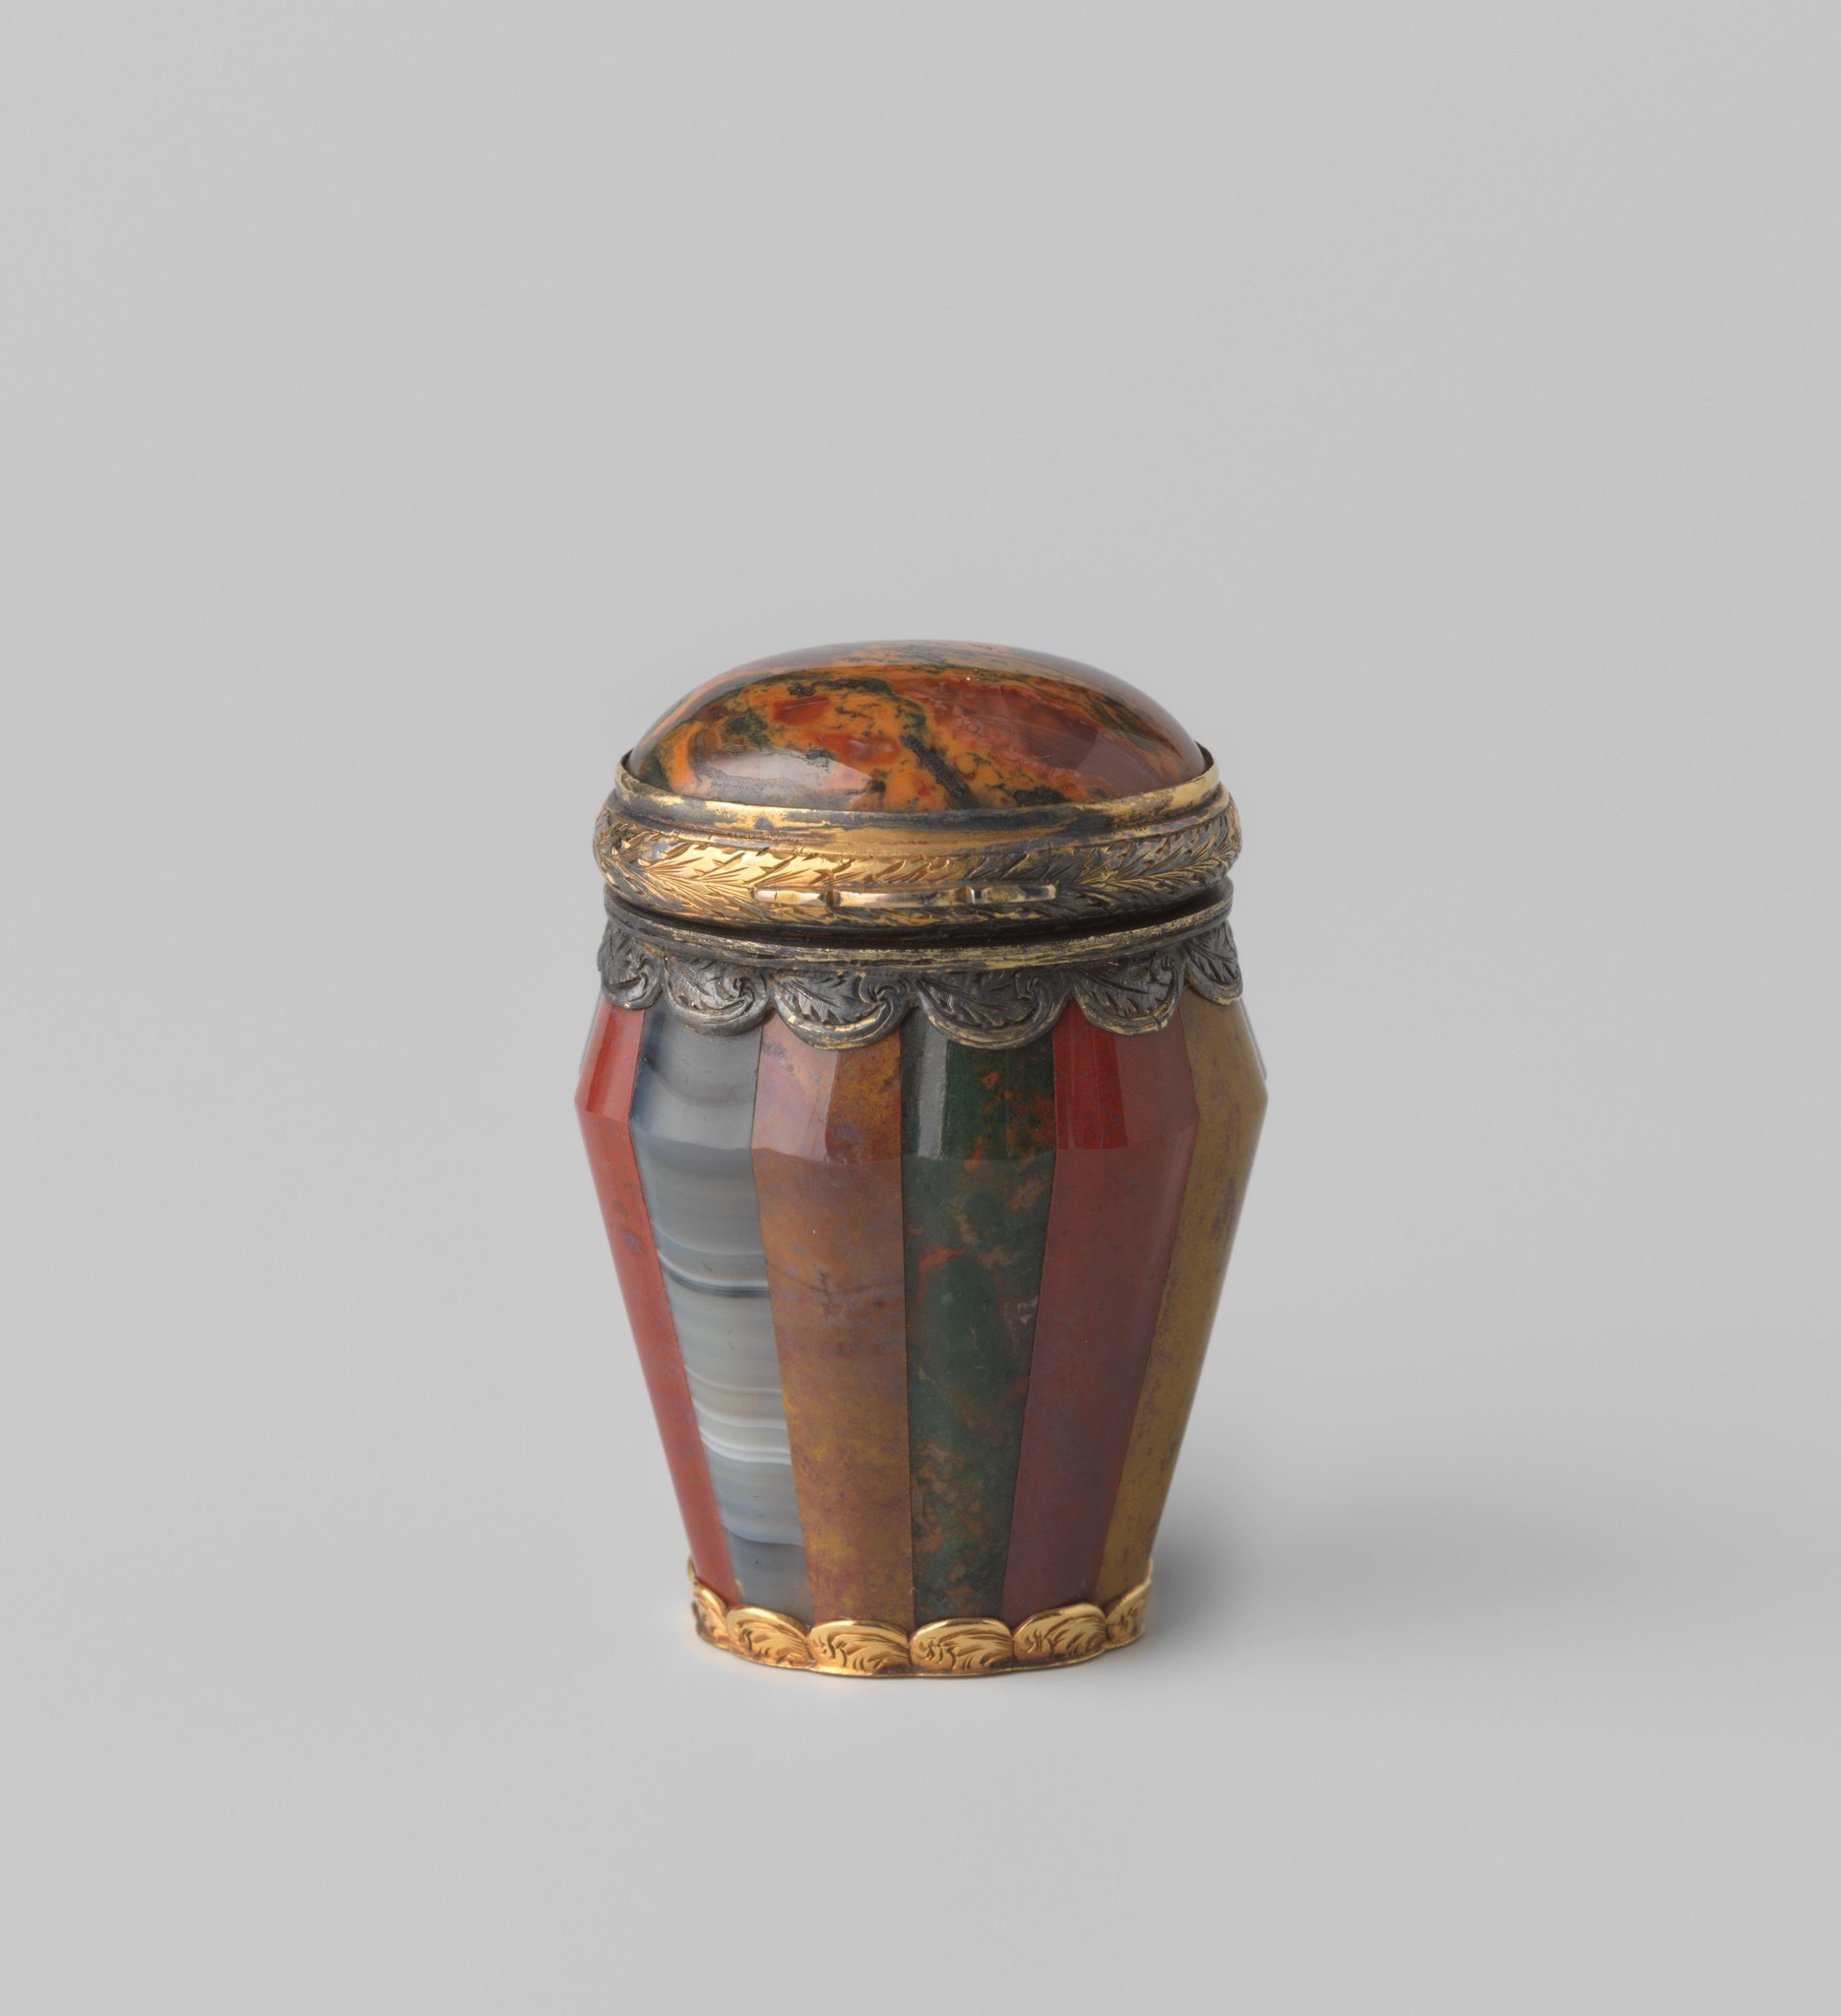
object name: vinaigrettehouder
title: Ovale vinaigrettehouder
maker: Anonymous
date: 1790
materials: gemstone, silver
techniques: gilding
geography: great britain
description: Ovale vinaigrettehouder (?) van verguld zilver met edelstenen. Het lichaam verbreedt zich eerst om zich daarna te verjongen. De wand is opgebouwd uit 12 segmentvormige staande panelen van verschillende soorten edelstenen. In de vinaigrette een verguld zilveren binnenbakje.